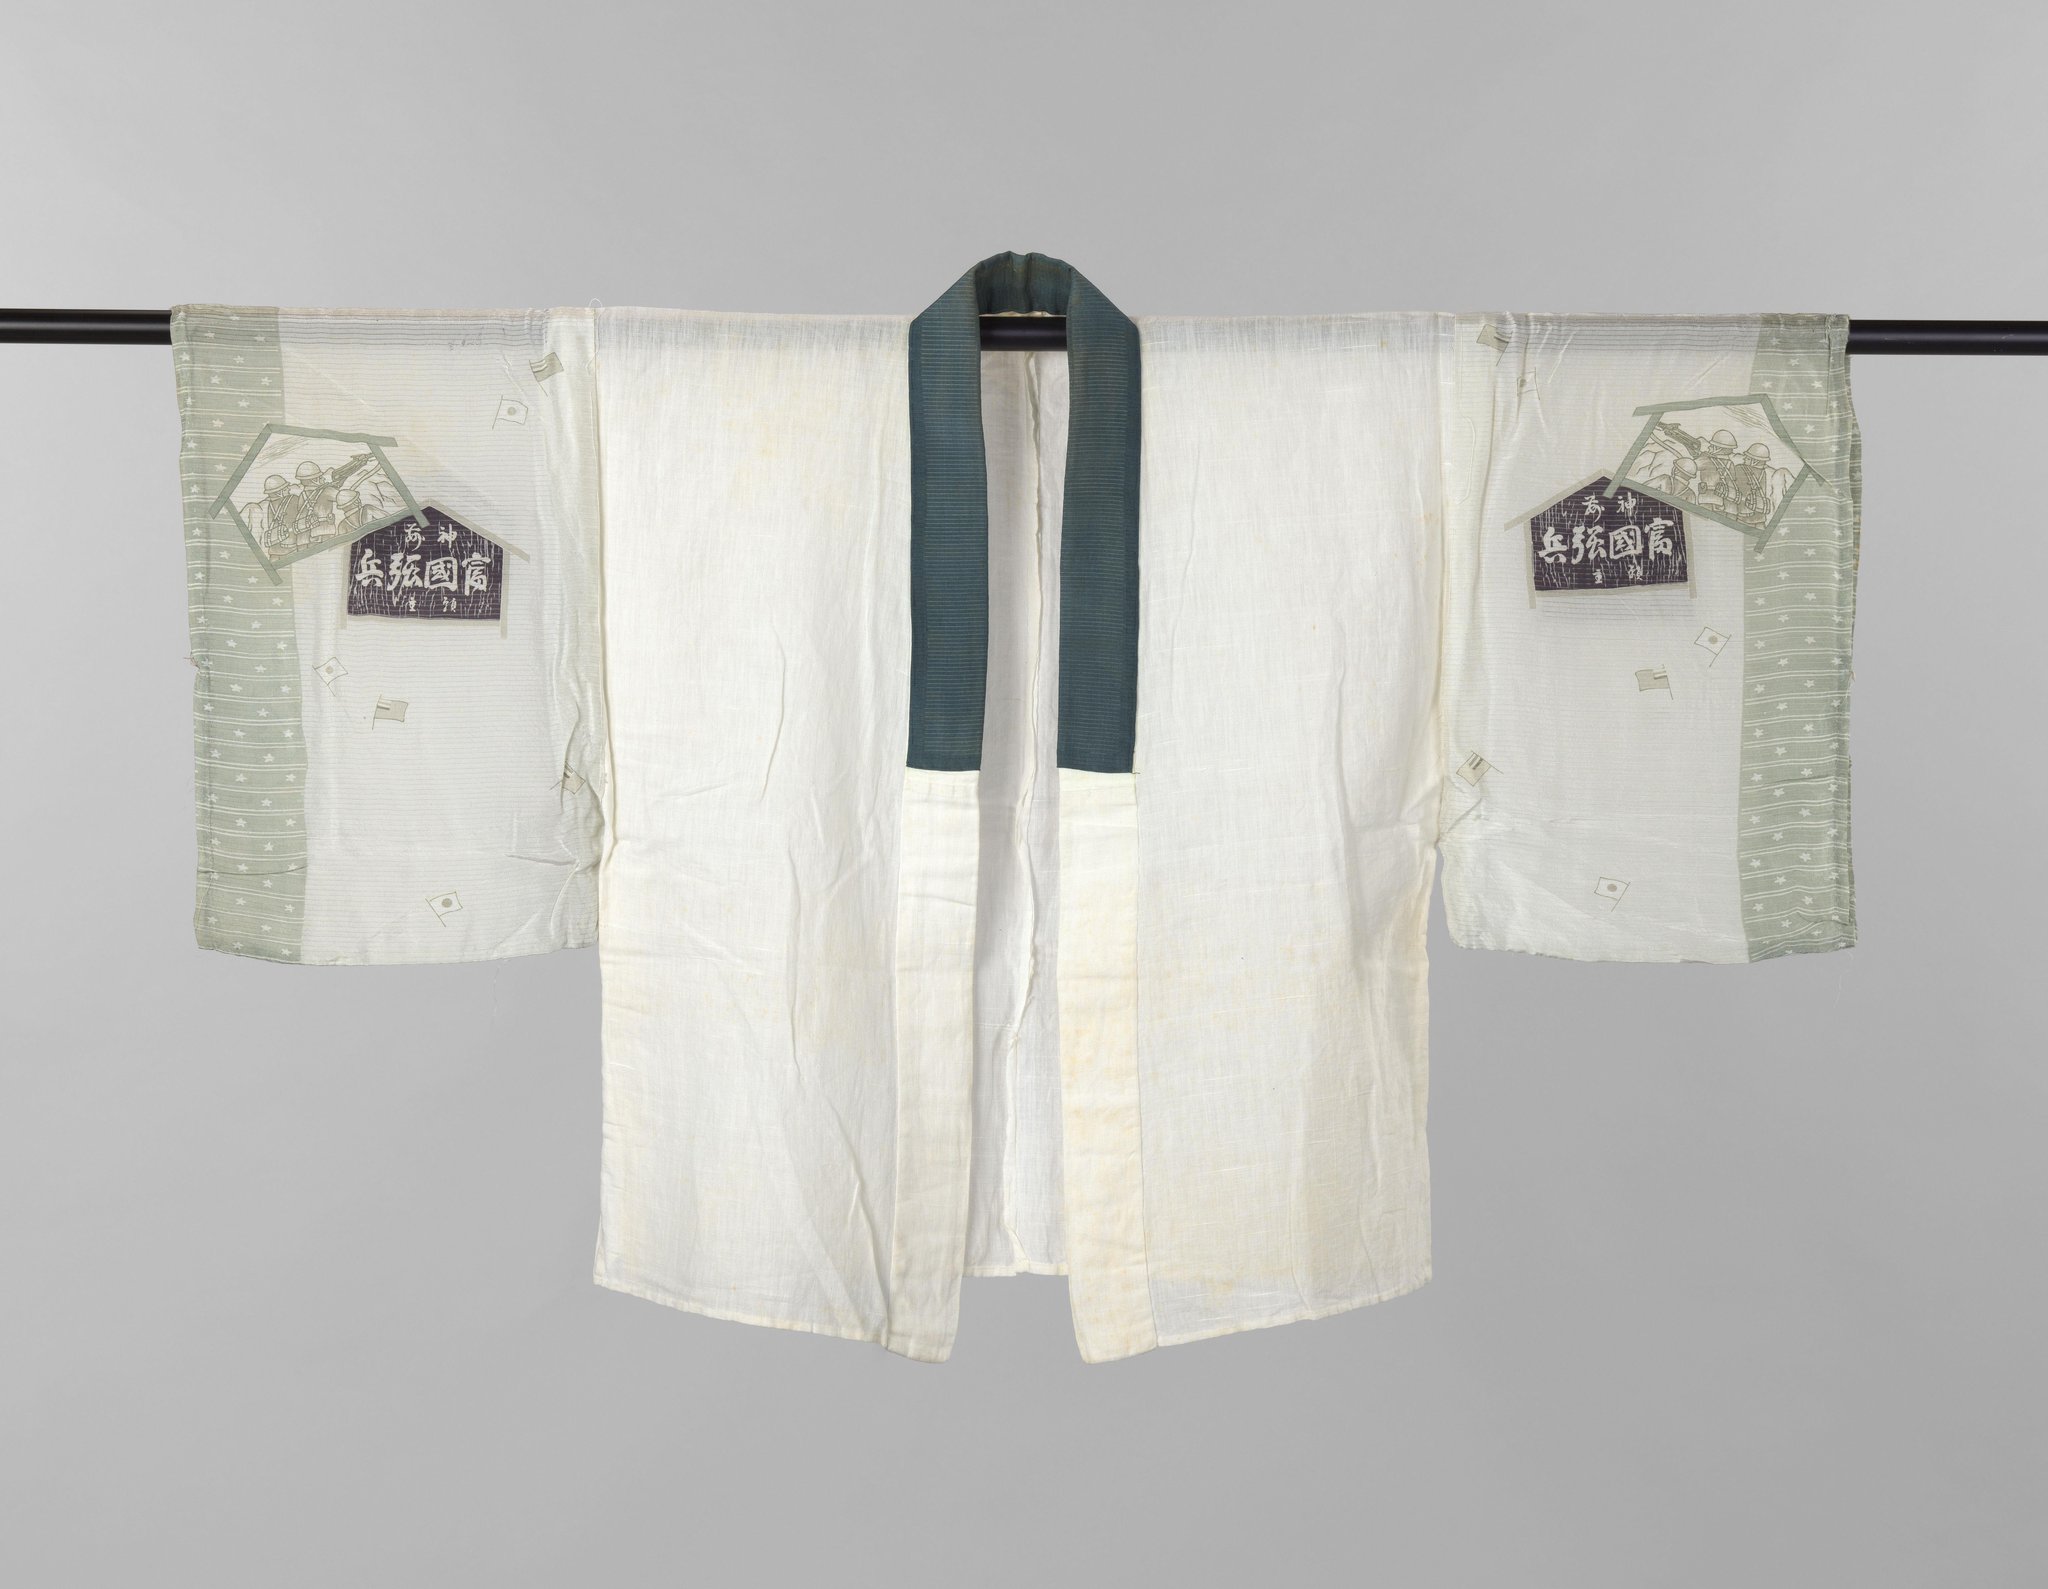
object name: kimono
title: Mannen haori met slogan Fukoku Kyohei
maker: Anonymous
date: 1930-1935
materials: silk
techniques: weave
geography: japan